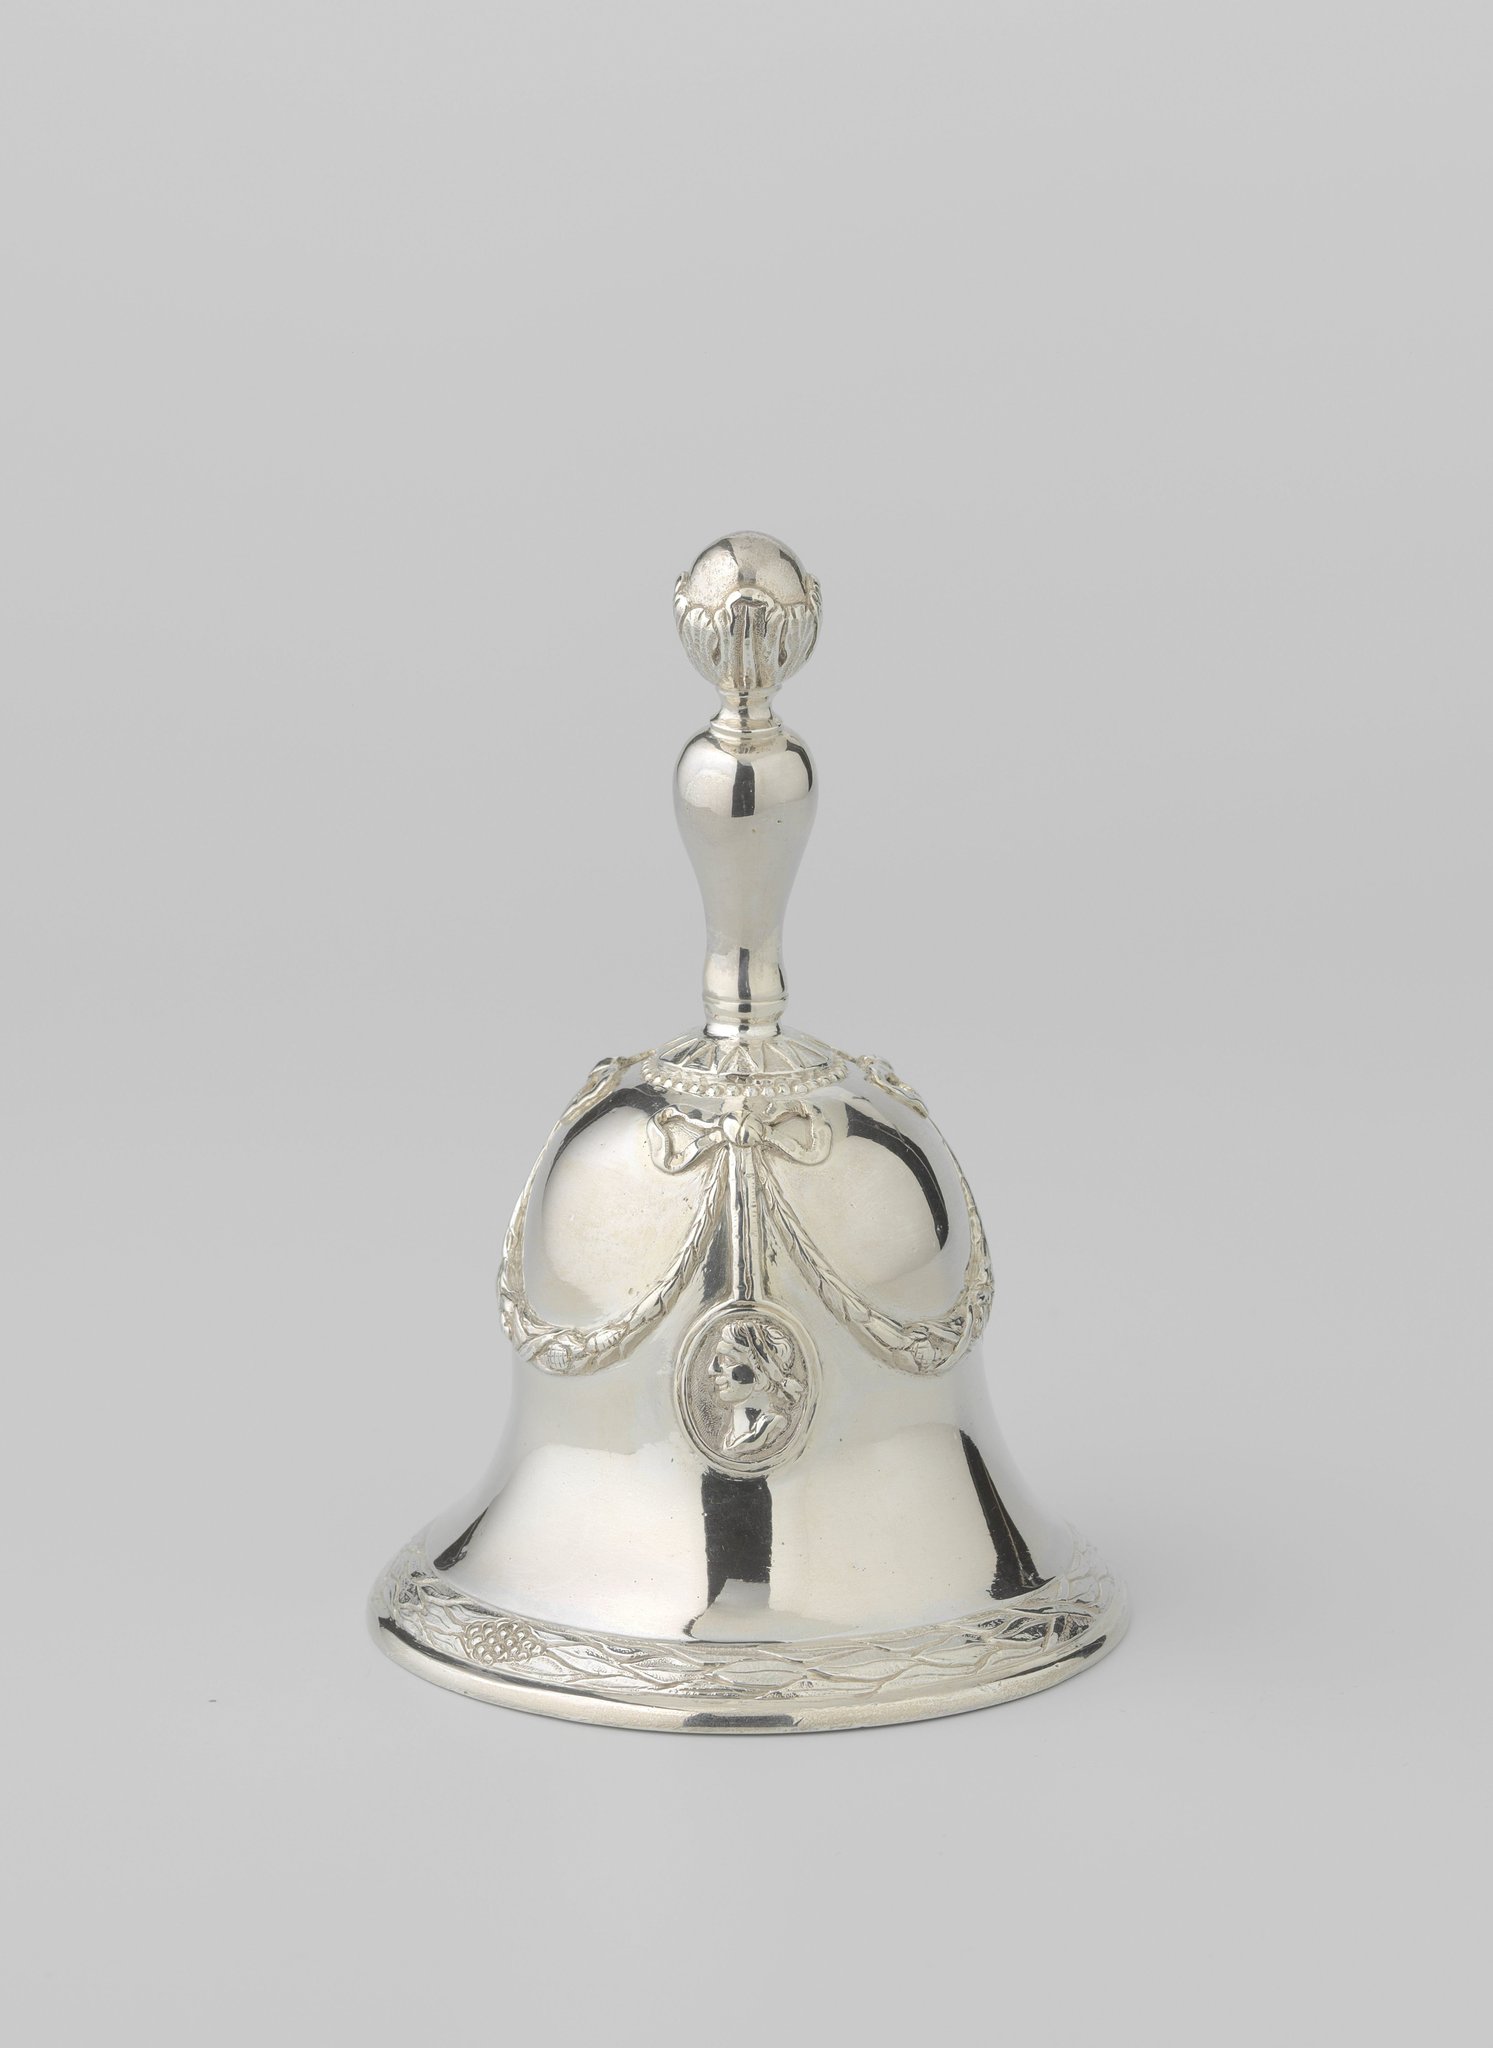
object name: handbell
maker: barend swierinck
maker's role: silversmith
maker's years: 1733-1797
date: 1778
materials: silver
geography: amsterdam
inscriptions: alloy mark, date letter: ‘T’, maker's mark, town mark, duty mark: ‘I’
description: Table bell. Silver. Amsterdam, 1778, attributed to Barend Swiering.